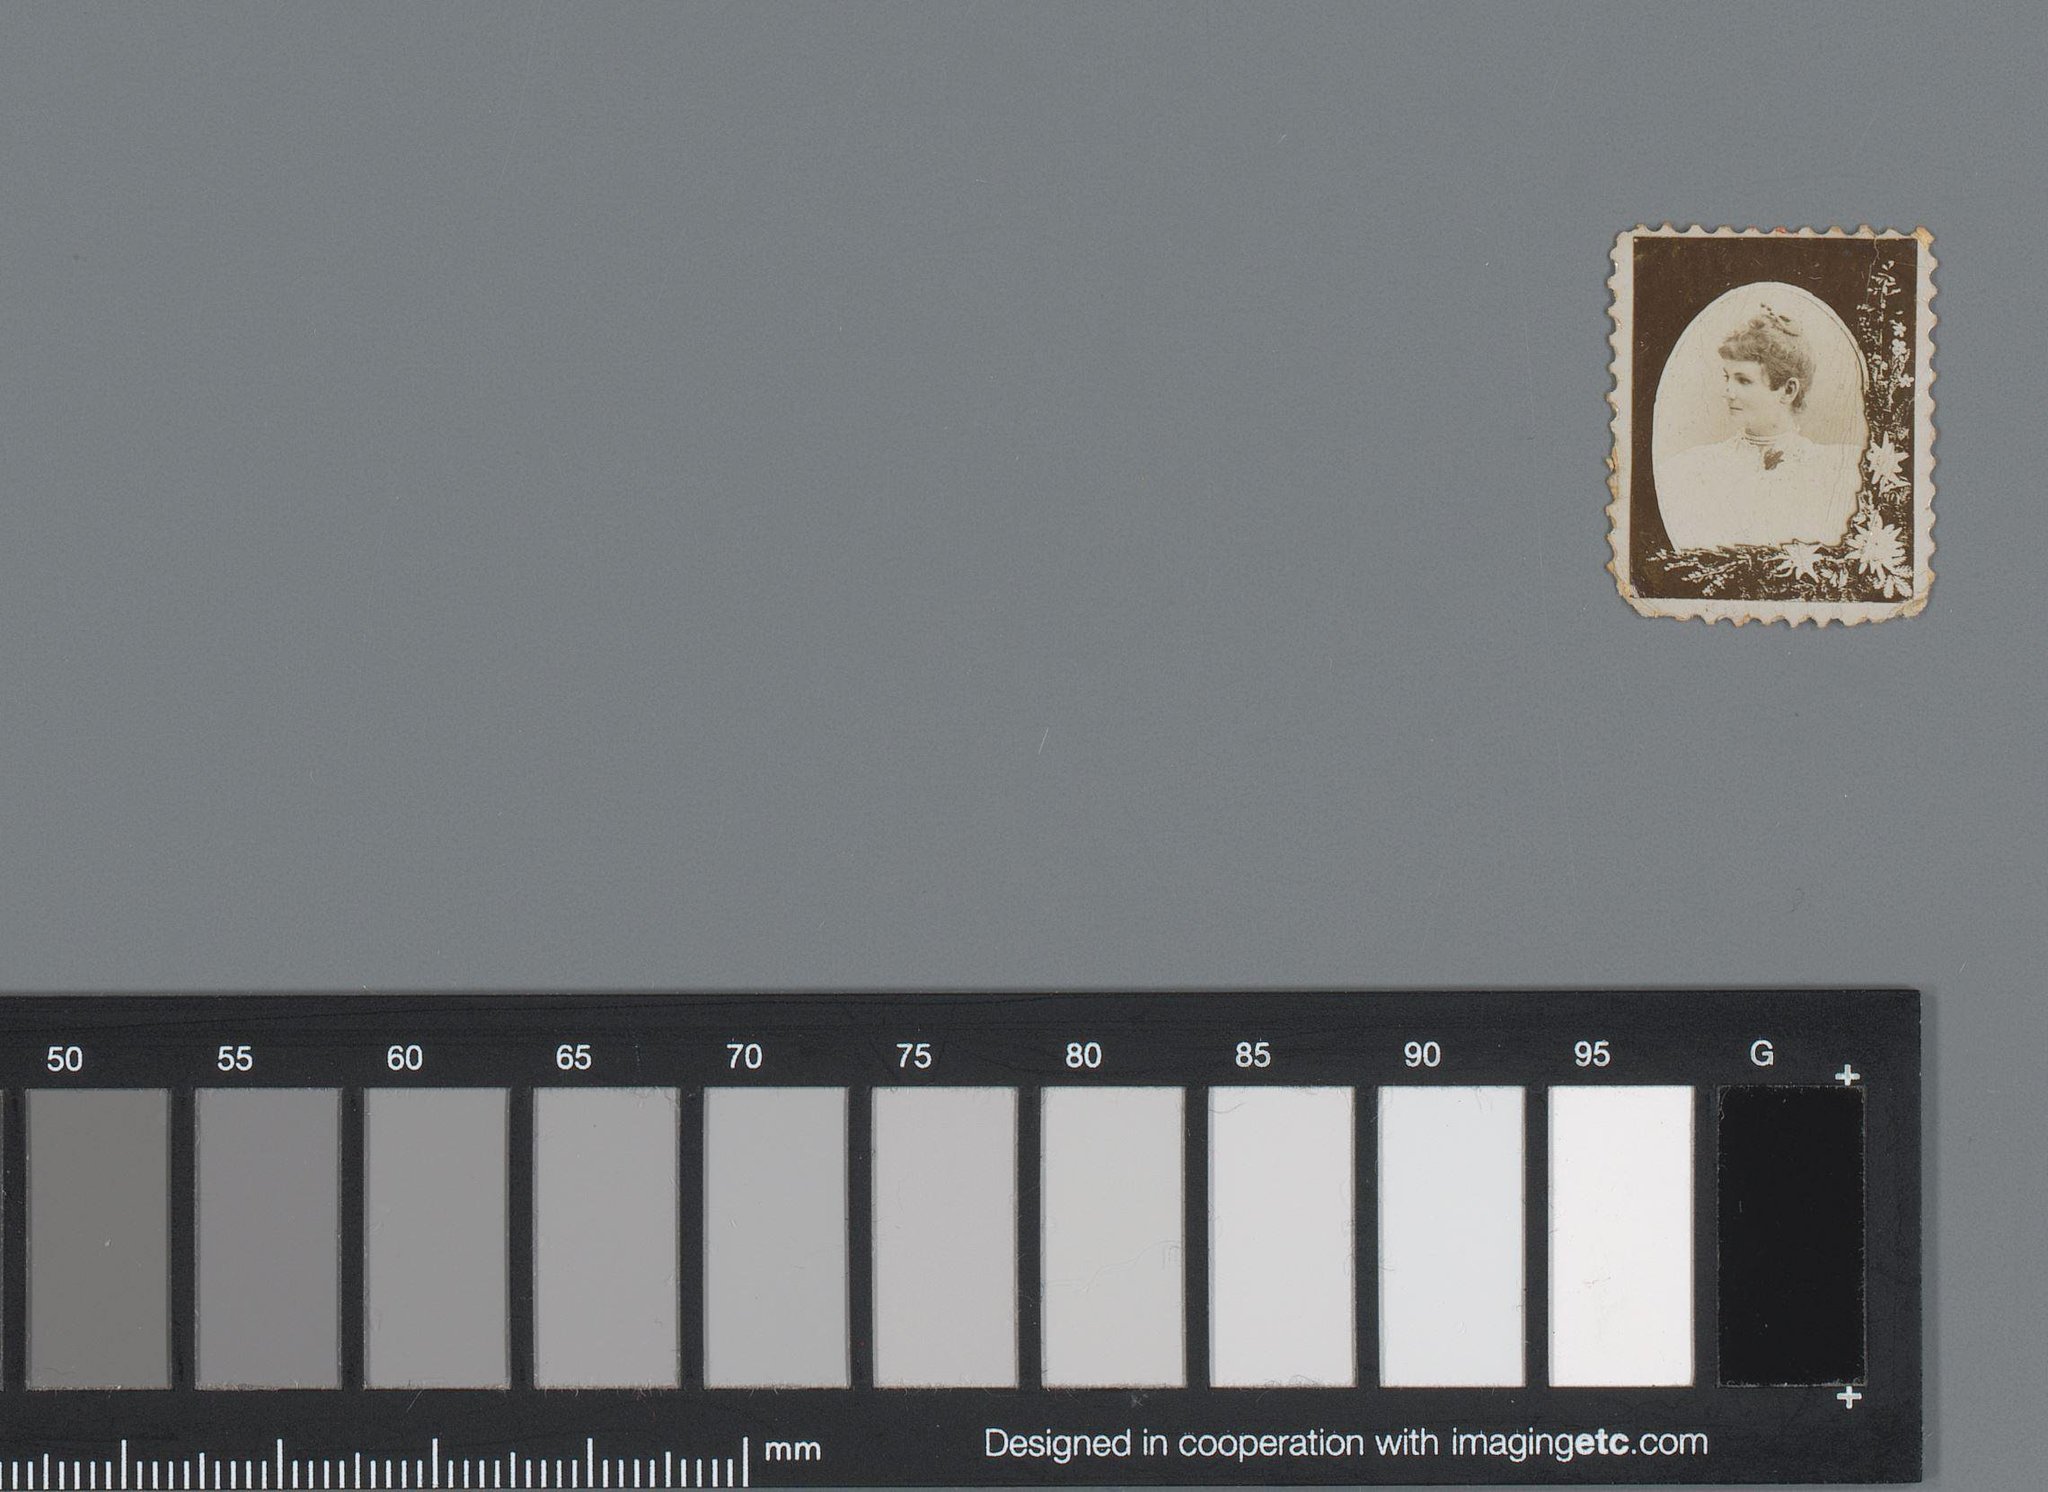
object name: postage stamp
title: Postzegelfoto met portret van een onbekende jonge vrouw, omlijst door bloemenranken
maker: Anonymous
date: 1890-1910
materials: paper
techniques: gelatin silver print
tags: adolescent, young woman, maiden, anonymous historical person portrayed